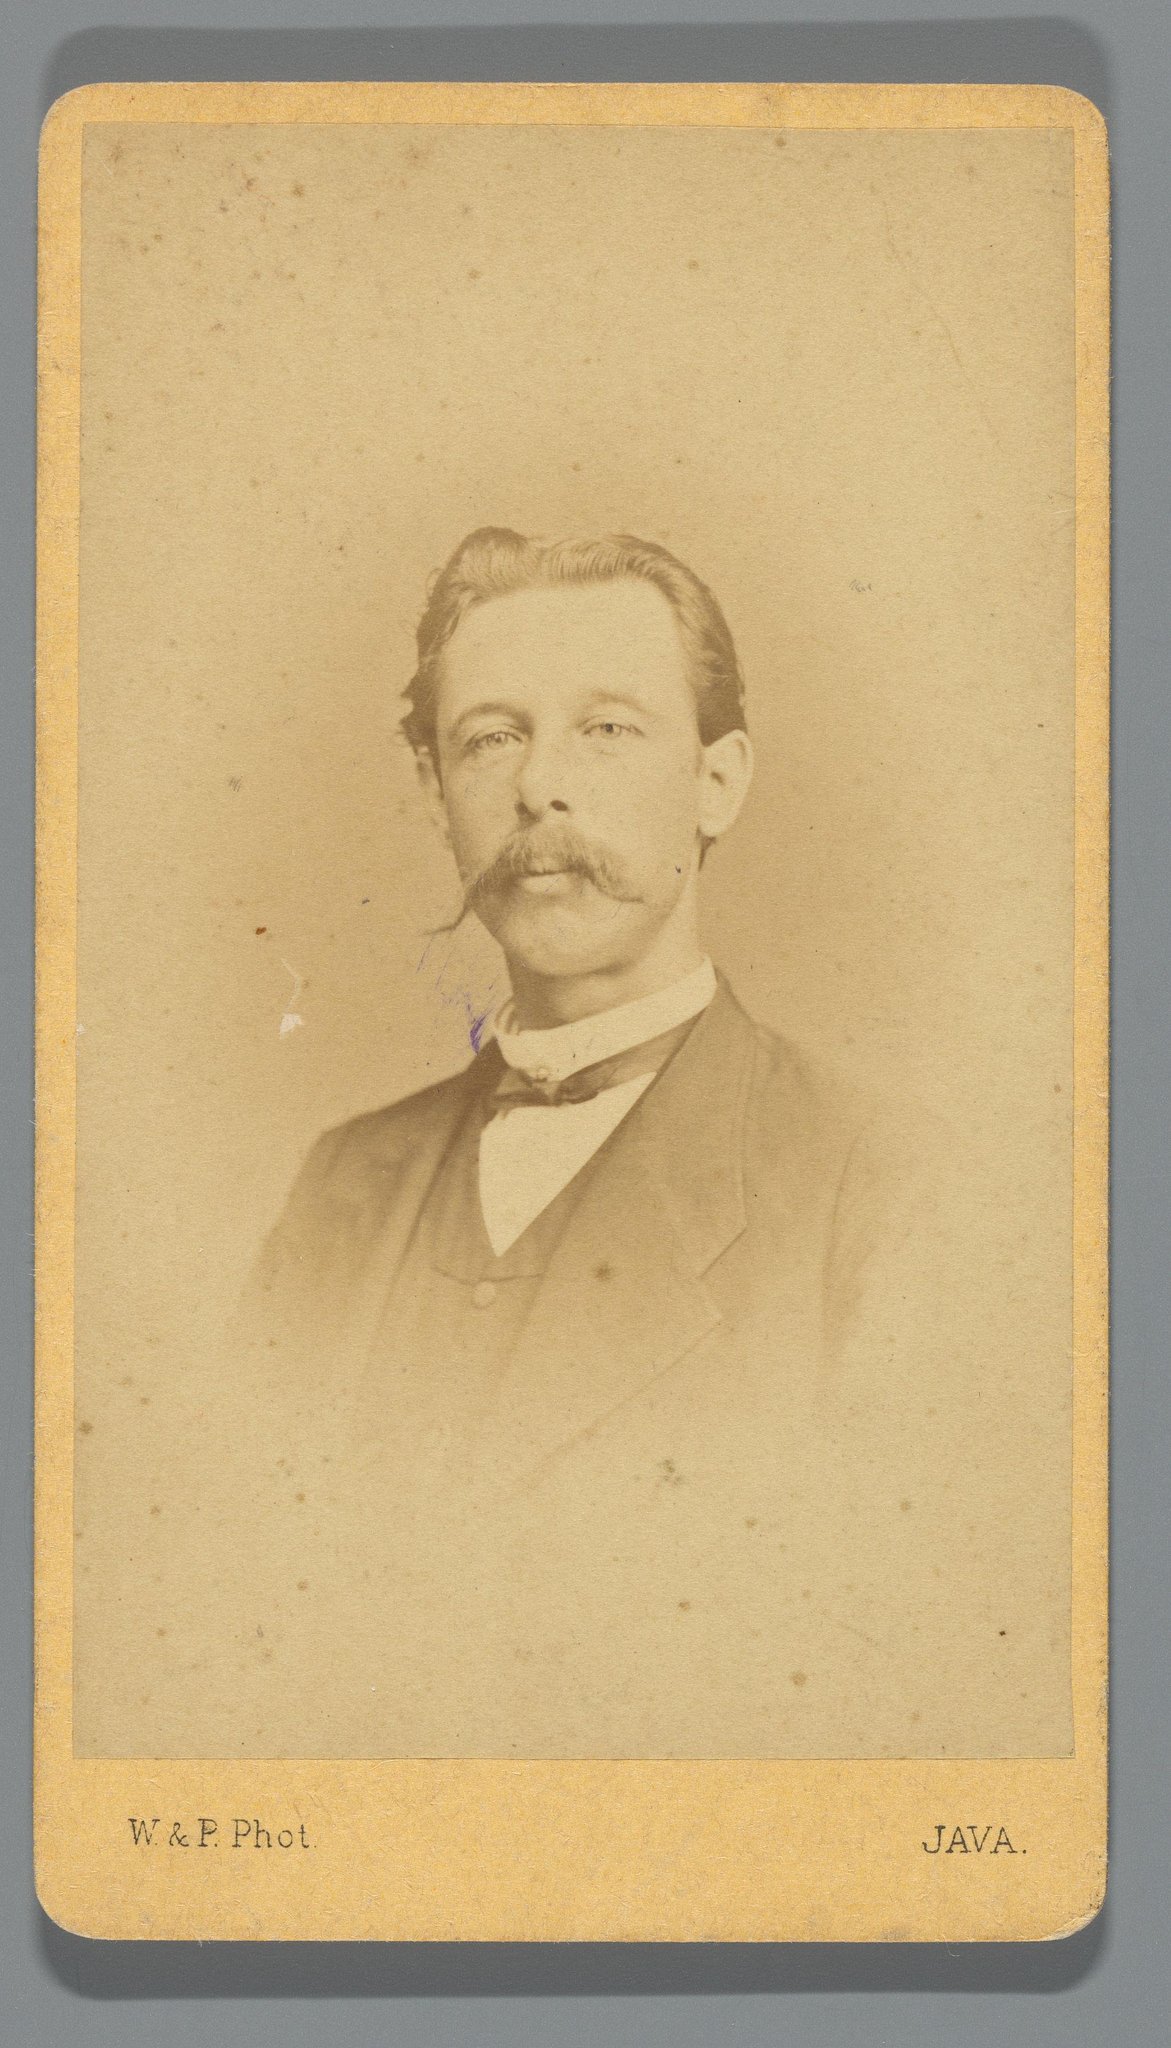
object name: photograph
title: Portret van A.W. Holle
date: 1855-1910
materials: cardboard, photographic support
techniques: albumen print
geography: java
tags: a.w. holle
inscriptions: name: ‘W. & P. Phot. JAVA’, name: ‘WOODBURY & PAGE , / PHOTOGRAPHERS / JAVA.’, name: ‘AW Holle’